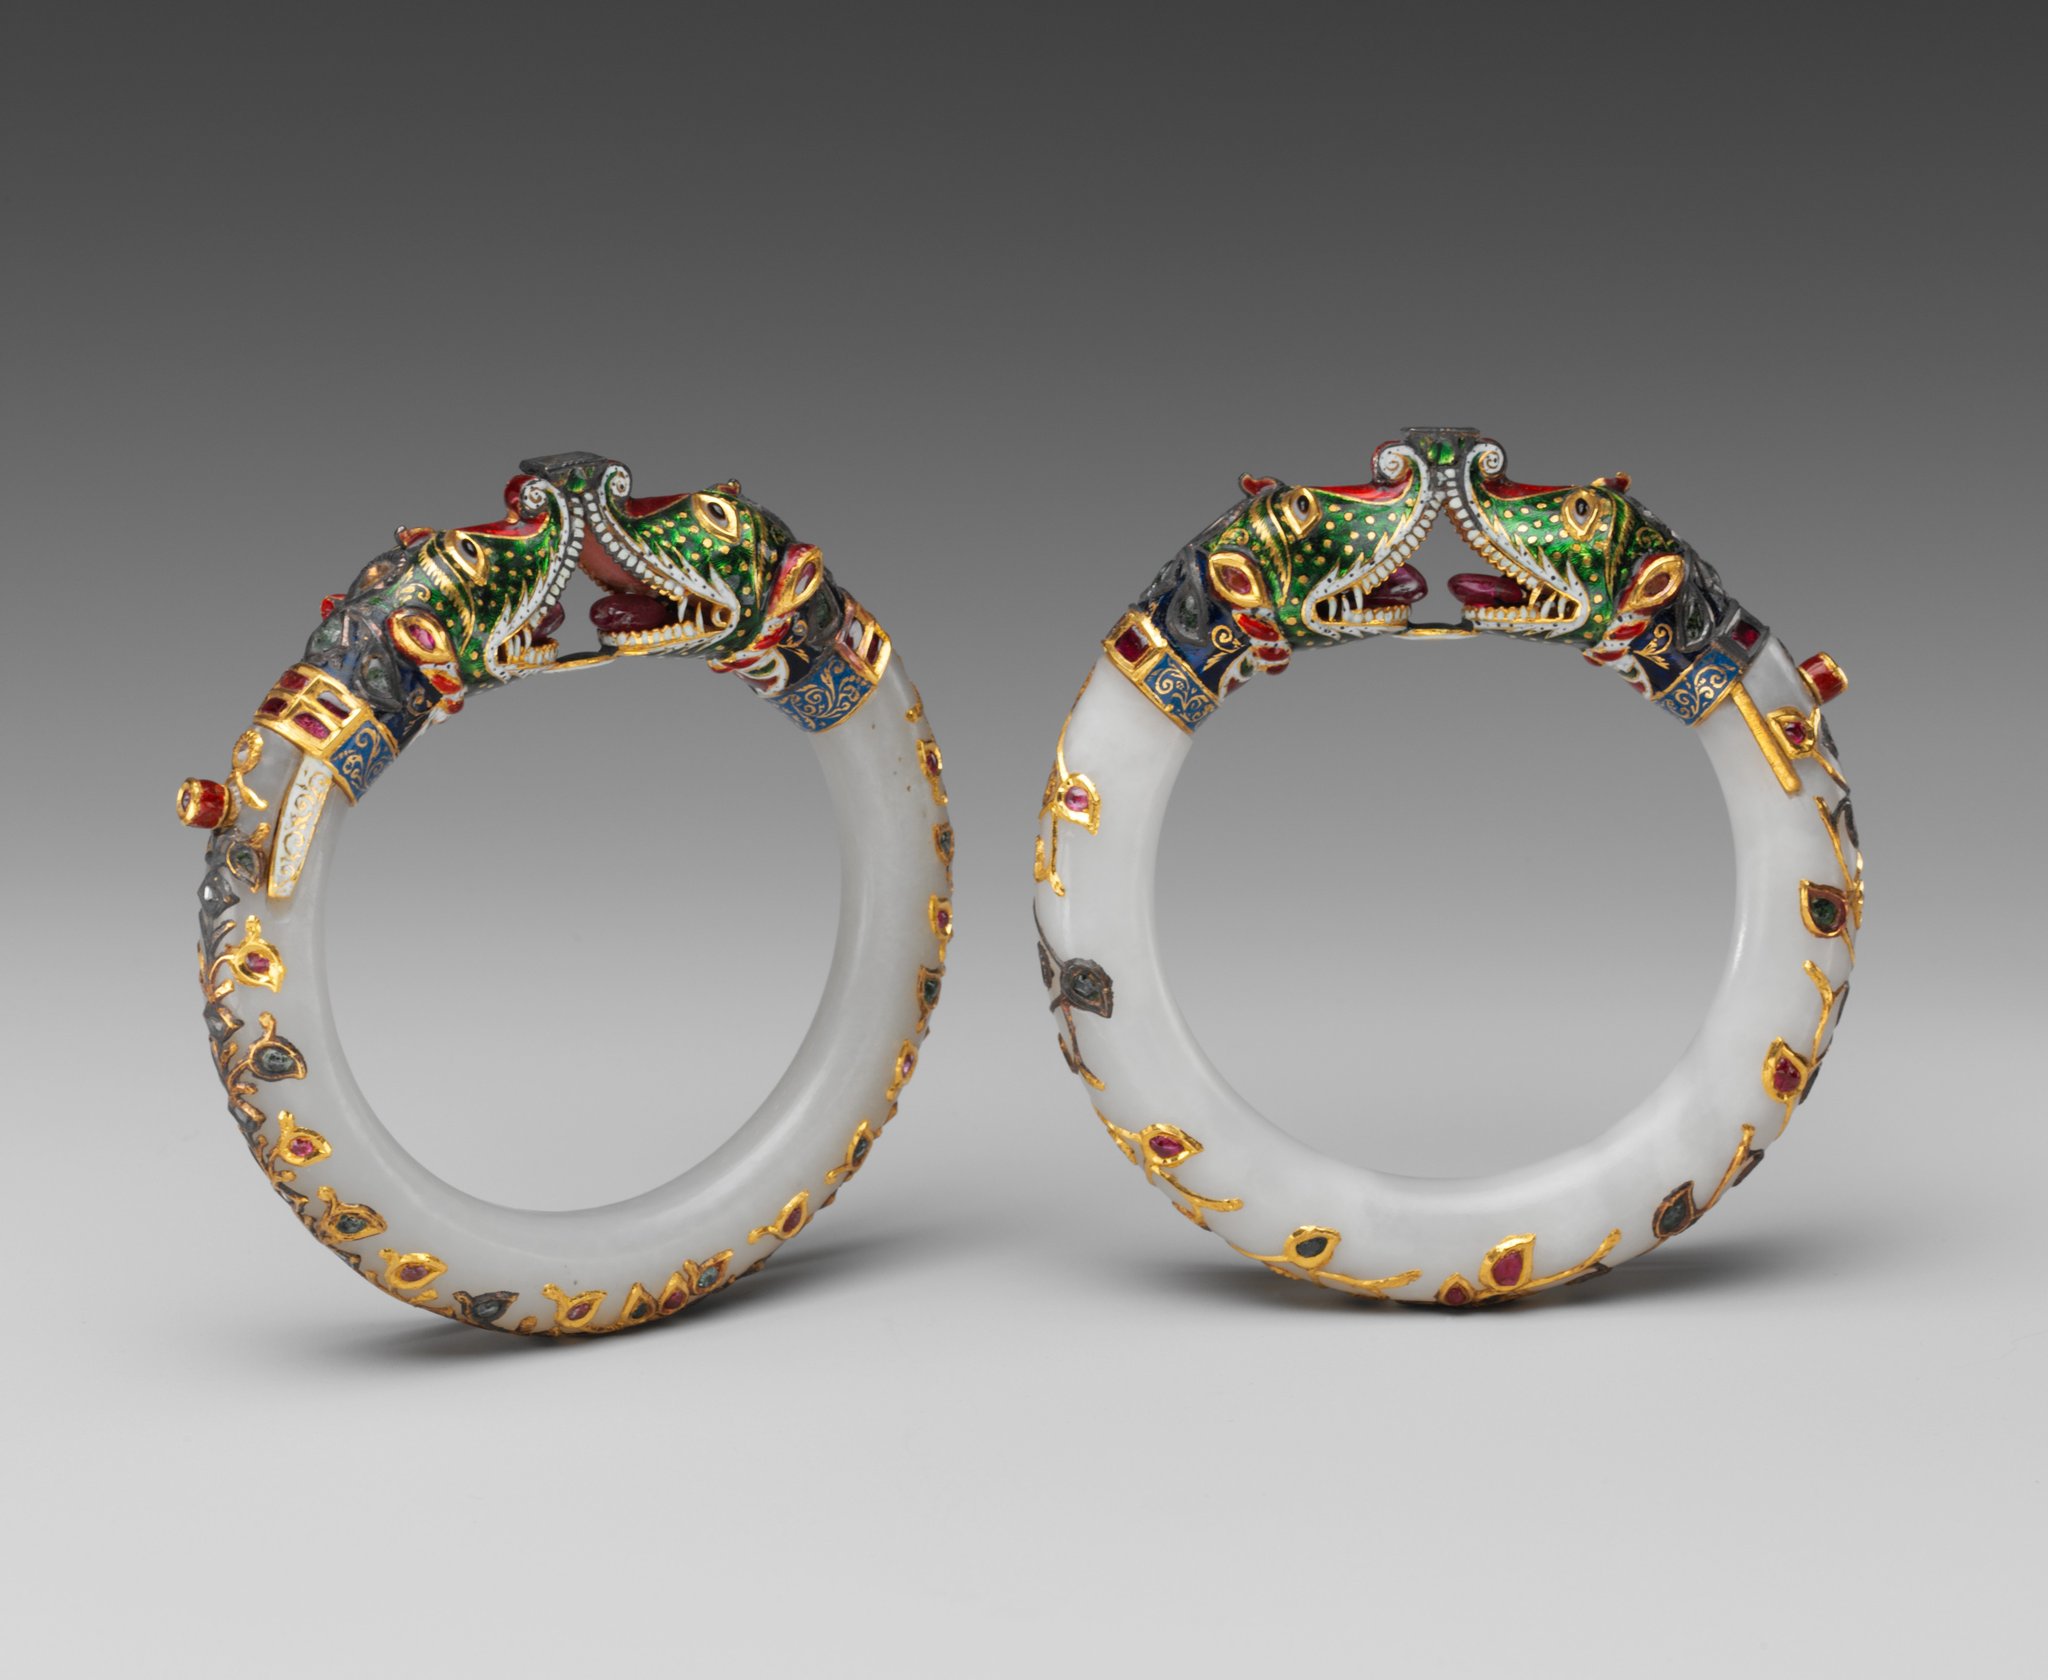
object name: bracelet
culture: indian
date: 1701-1900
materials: enamel, gold, jade, stone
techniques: inlay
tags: dragons